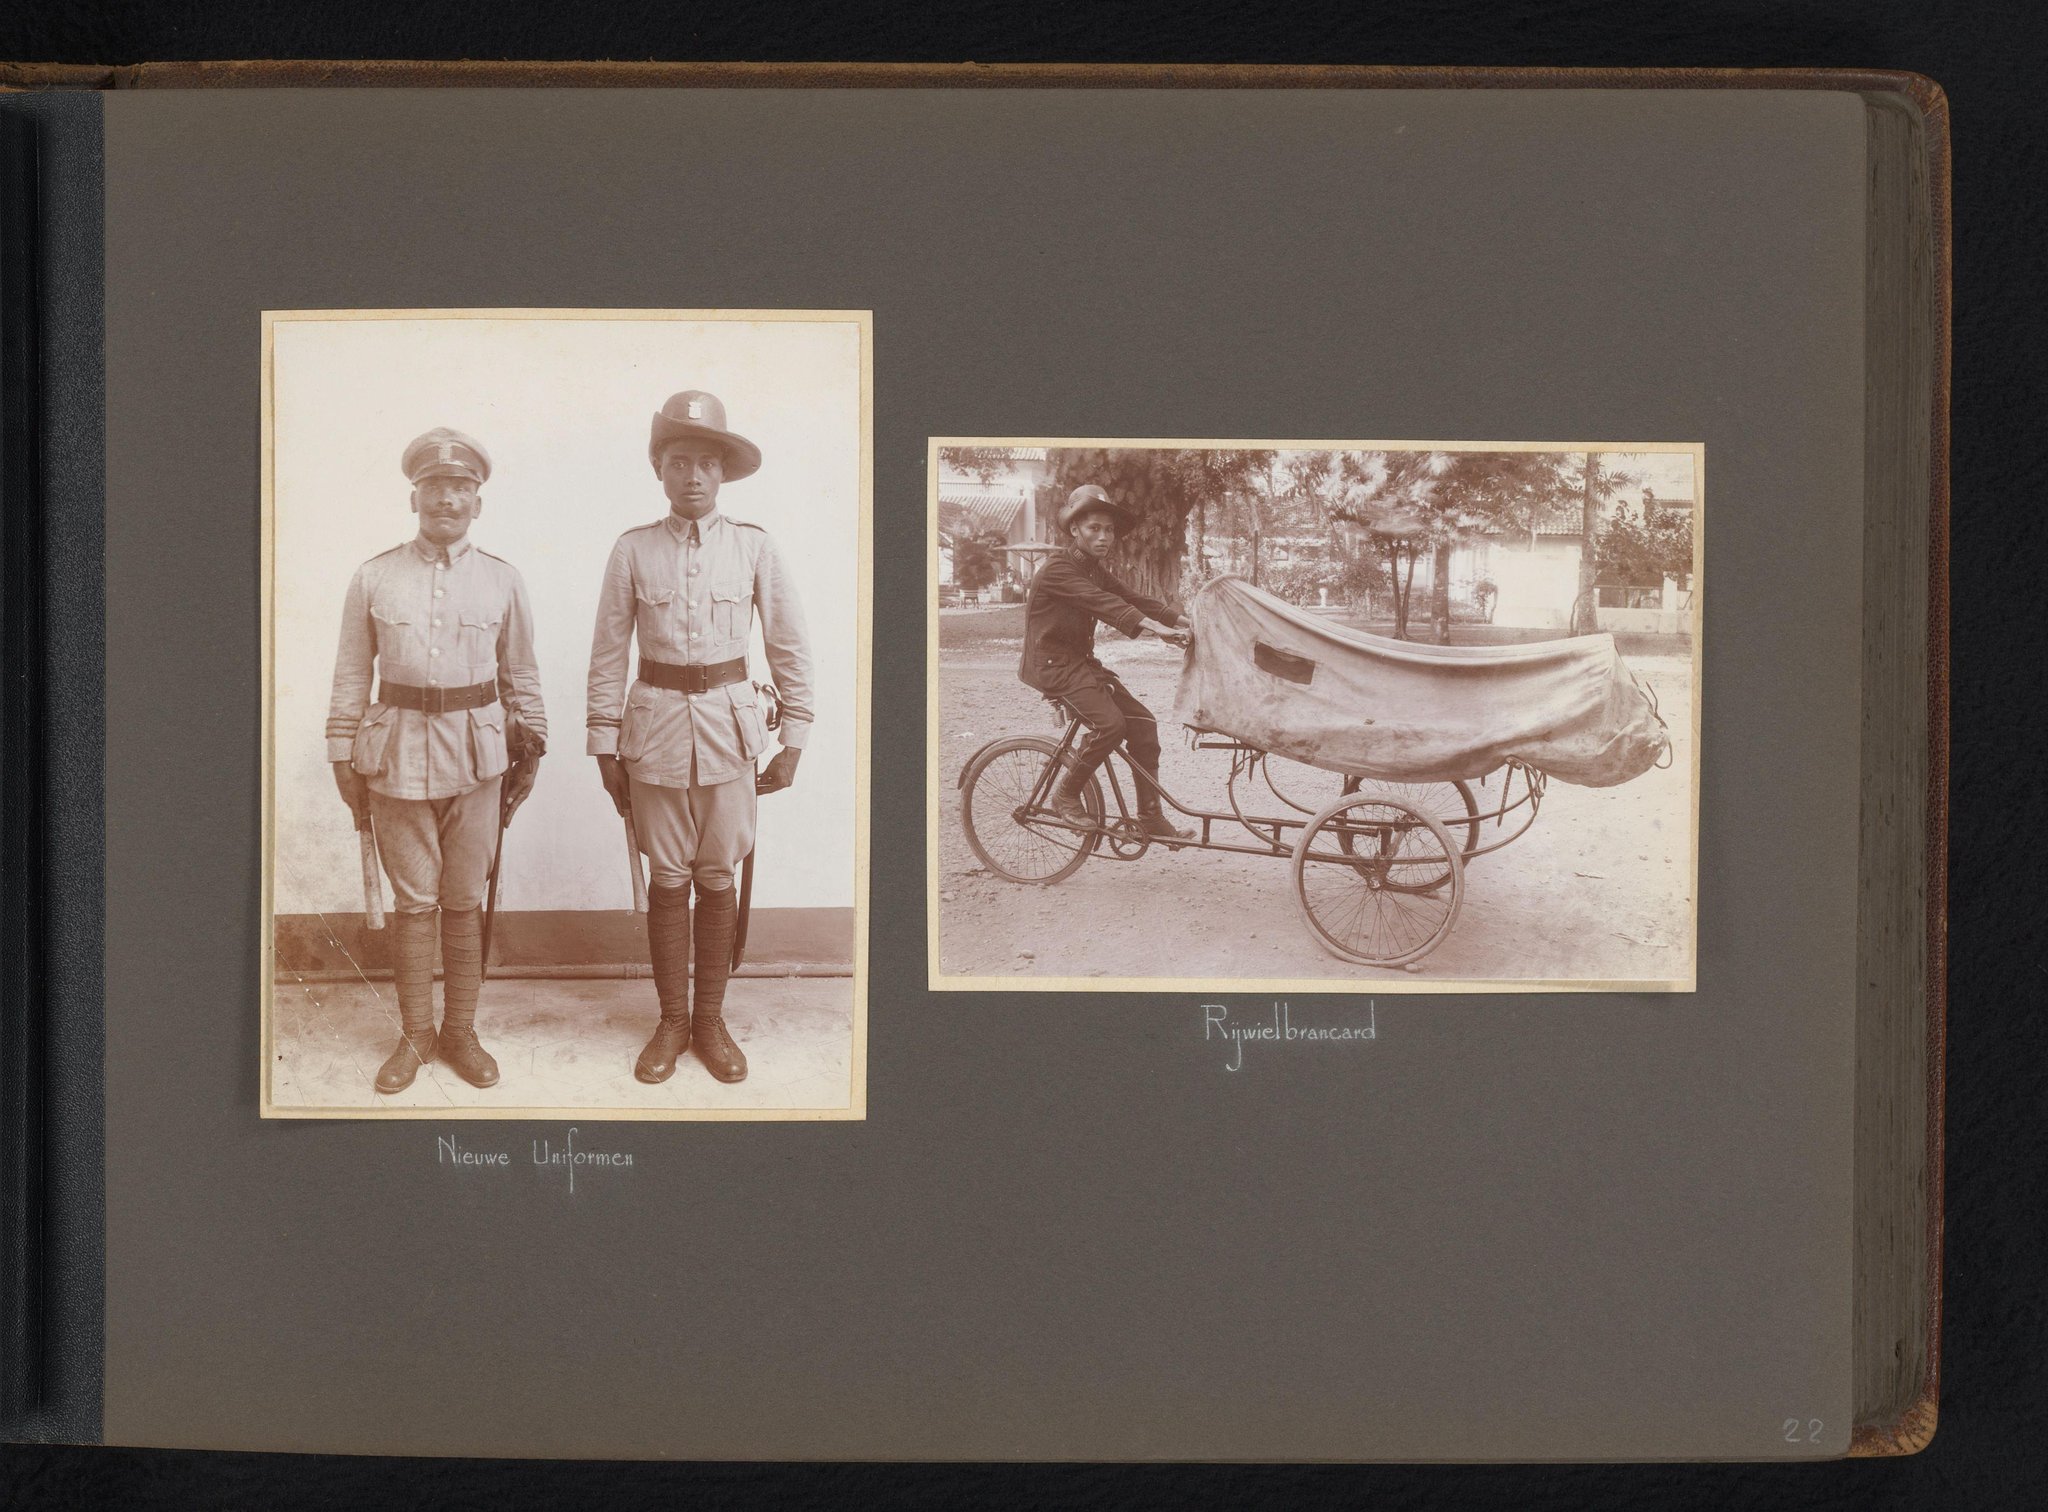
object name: album leaf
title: Nieuwe Uniformen / Rijwielbrancard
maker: Anonymous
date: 1925-1931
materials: cardboard, photographic support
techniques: collodion silver print, gelatin silver print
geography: batavia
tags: dutch east indies, the, batavia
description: Albumblad met twee foto's: nieuwe uniformen en een agent op een fiets met een brancard, politie te Batavia. Onderdeel van het fotoalbum aangeboden aan S. Koster door de Vereeniging van Hoogere Politie Ambtenaren in Nederlandsch-Indië in 1931.